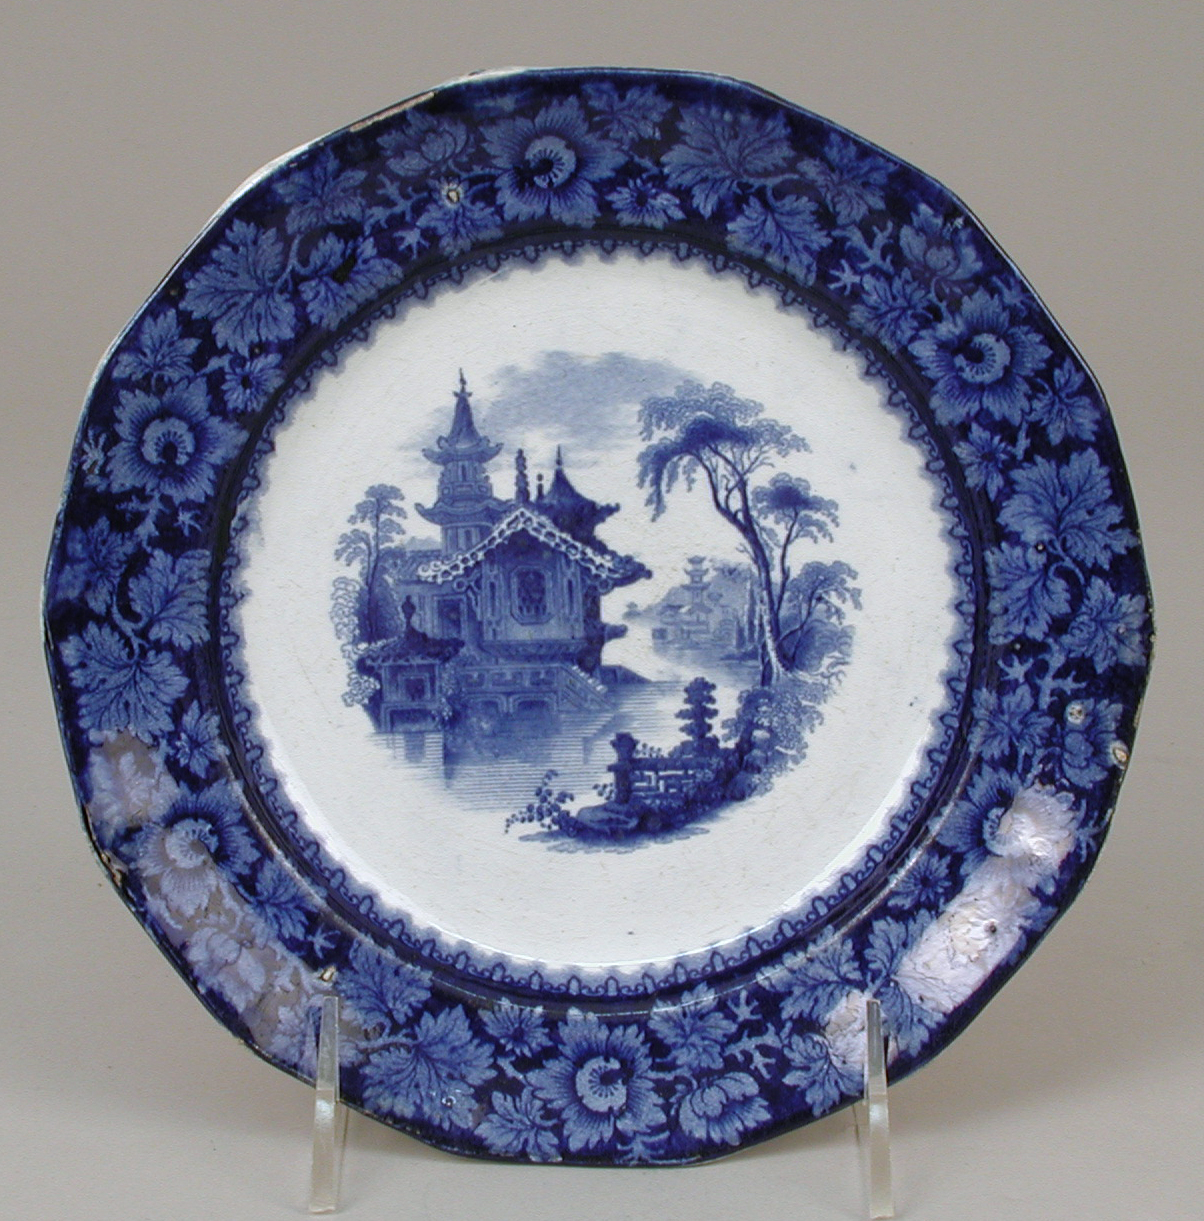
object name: plate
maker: george phillips, longport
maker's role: factory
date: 1845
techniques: transfer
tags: buildings,flowers,trees